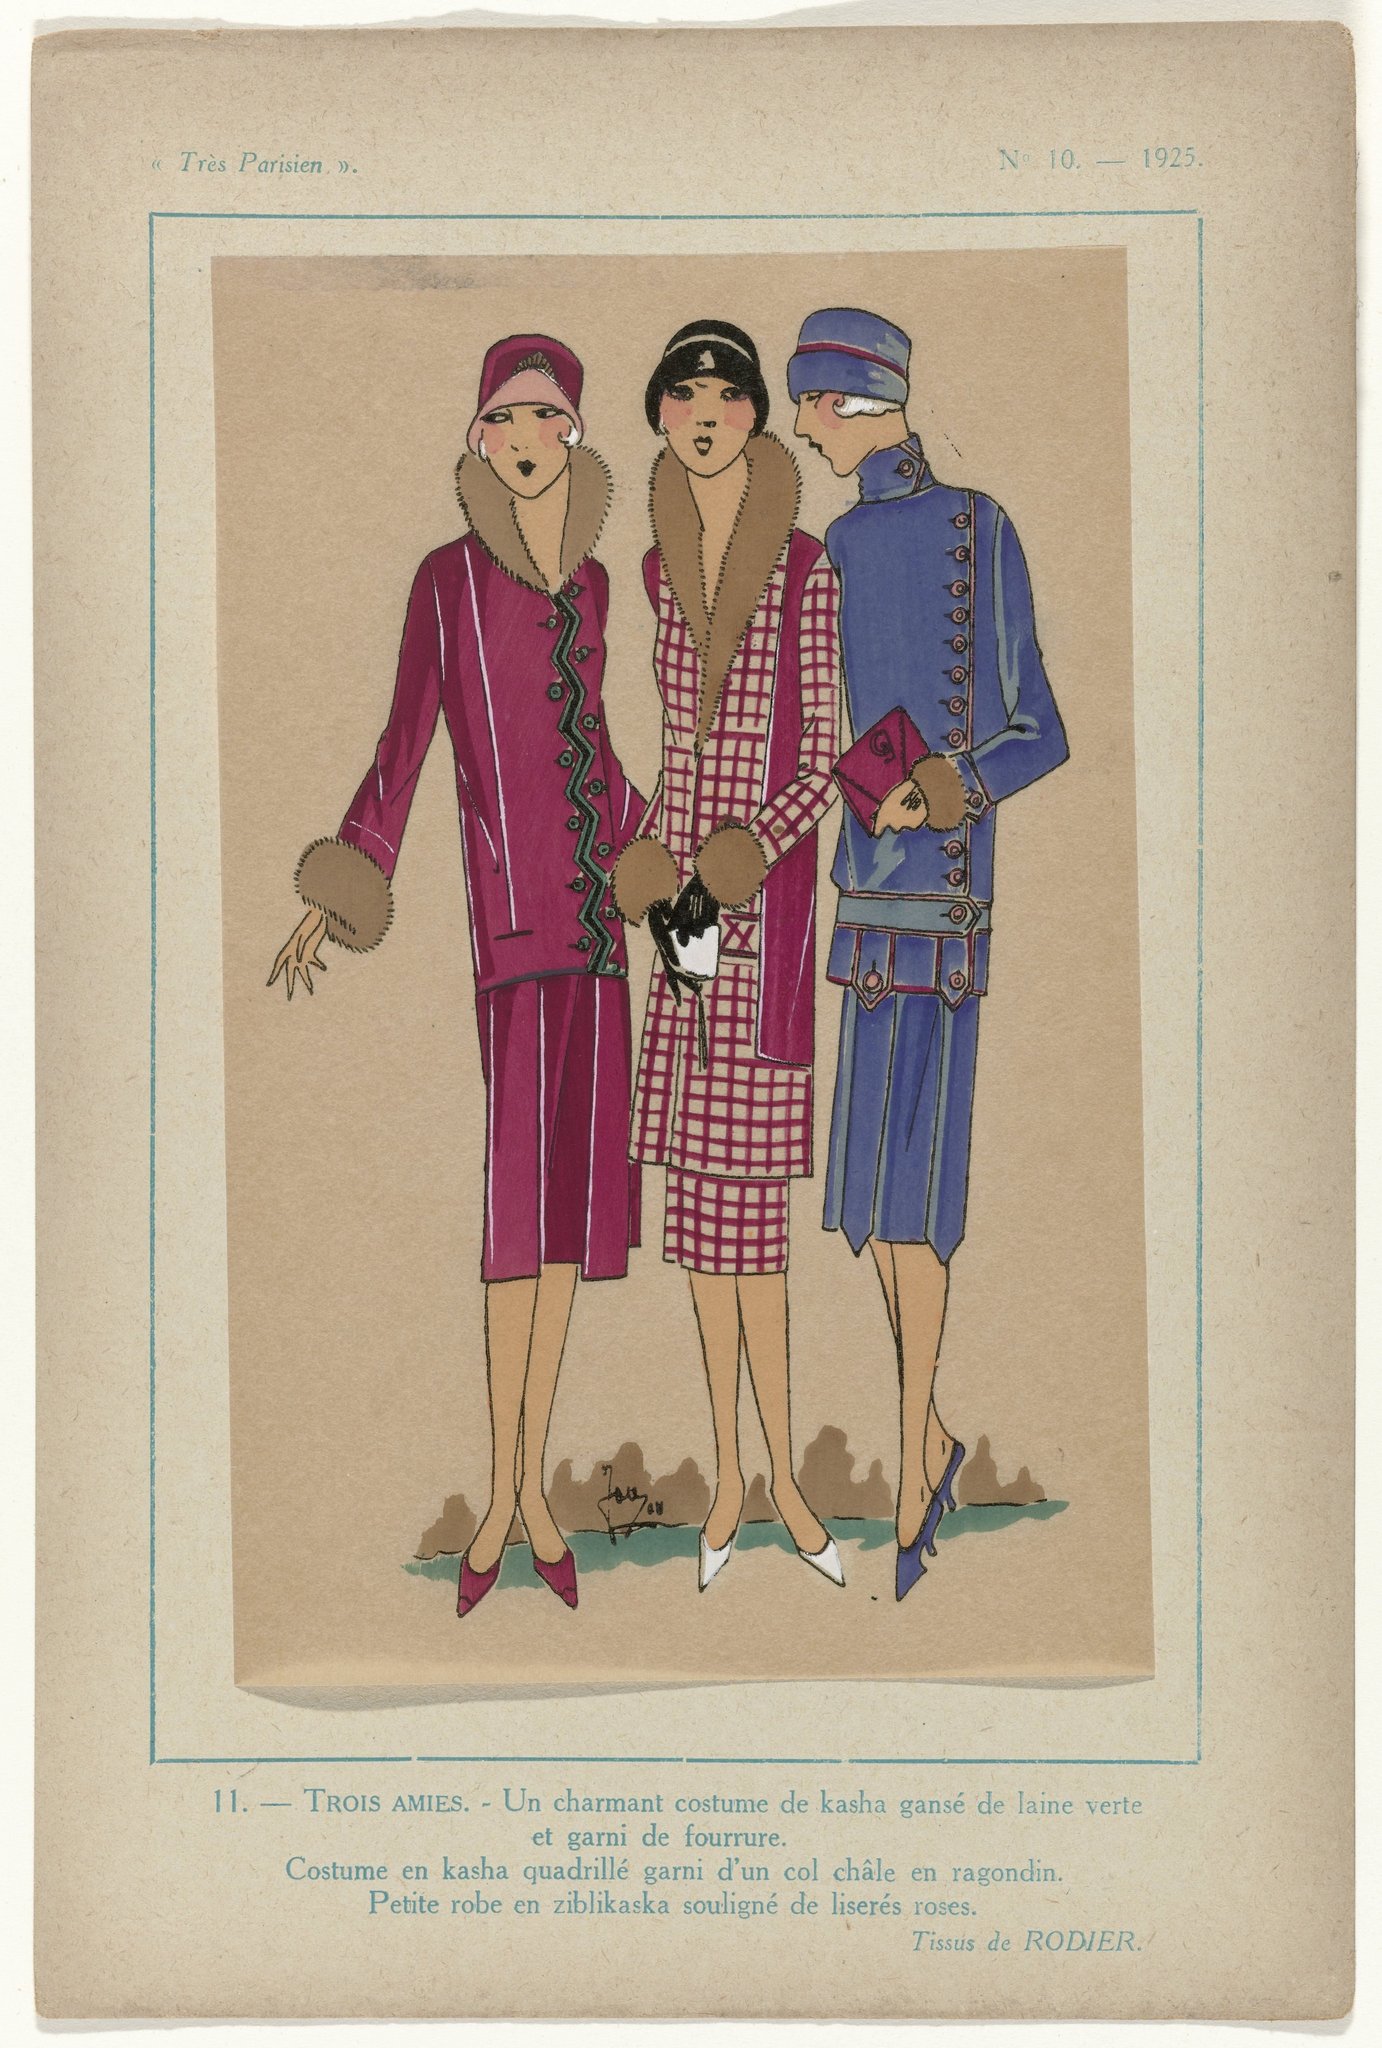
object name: fashion print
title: Très Parisien, 1925, No. 10, Pl. 11. - TROIS AMIES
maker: g-p. joumard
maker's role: publisher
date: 1925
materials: paper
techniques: hand coloring, letterpress printing, lithography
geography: paris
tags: fashion plates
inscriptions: date: ‘11. - TROIS AMIES. - Un charmant costume de kasha gansé de laine verte, et garni de fourrure. Costume en kasha quadrillé garni d'un col chale en ragondin. Petite robe en ziblikaska souligné de lisserés roses. Tissus de Rodier.’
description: Drie kostuums in stoffen van Rodier. Prent uit het modetijdschrift Très Parisien...La Mode, Le Chic, L'Élégance (1920-1936)